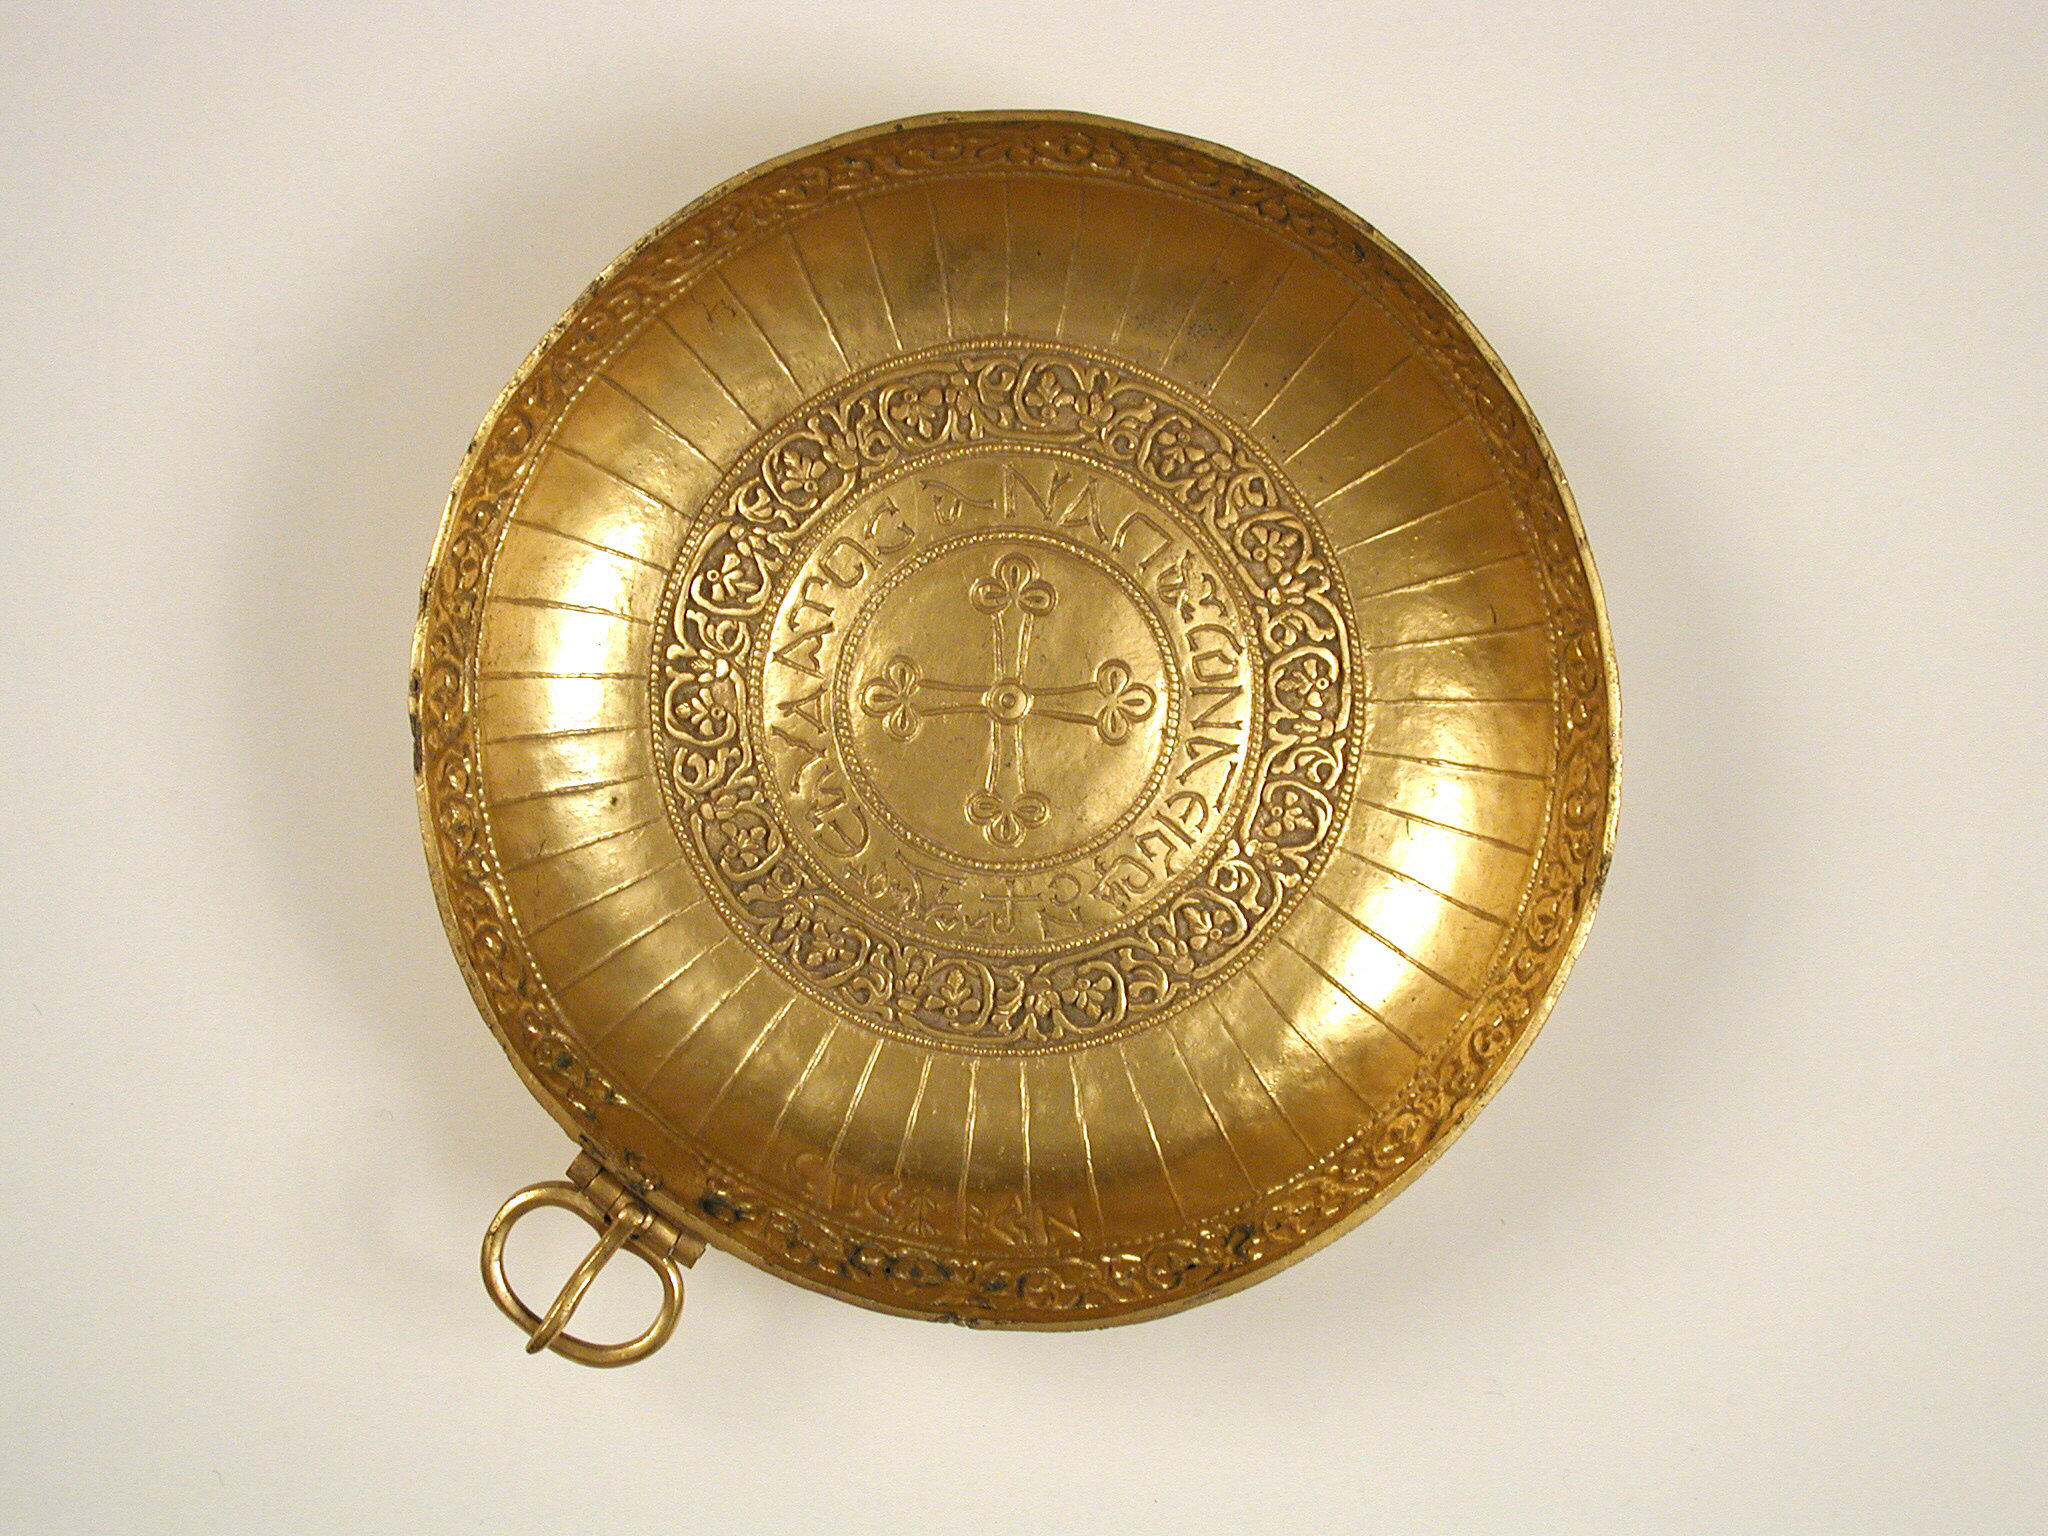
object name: cup or bratina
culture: scythian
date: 1801-1900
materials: gold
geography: hungary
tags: cross